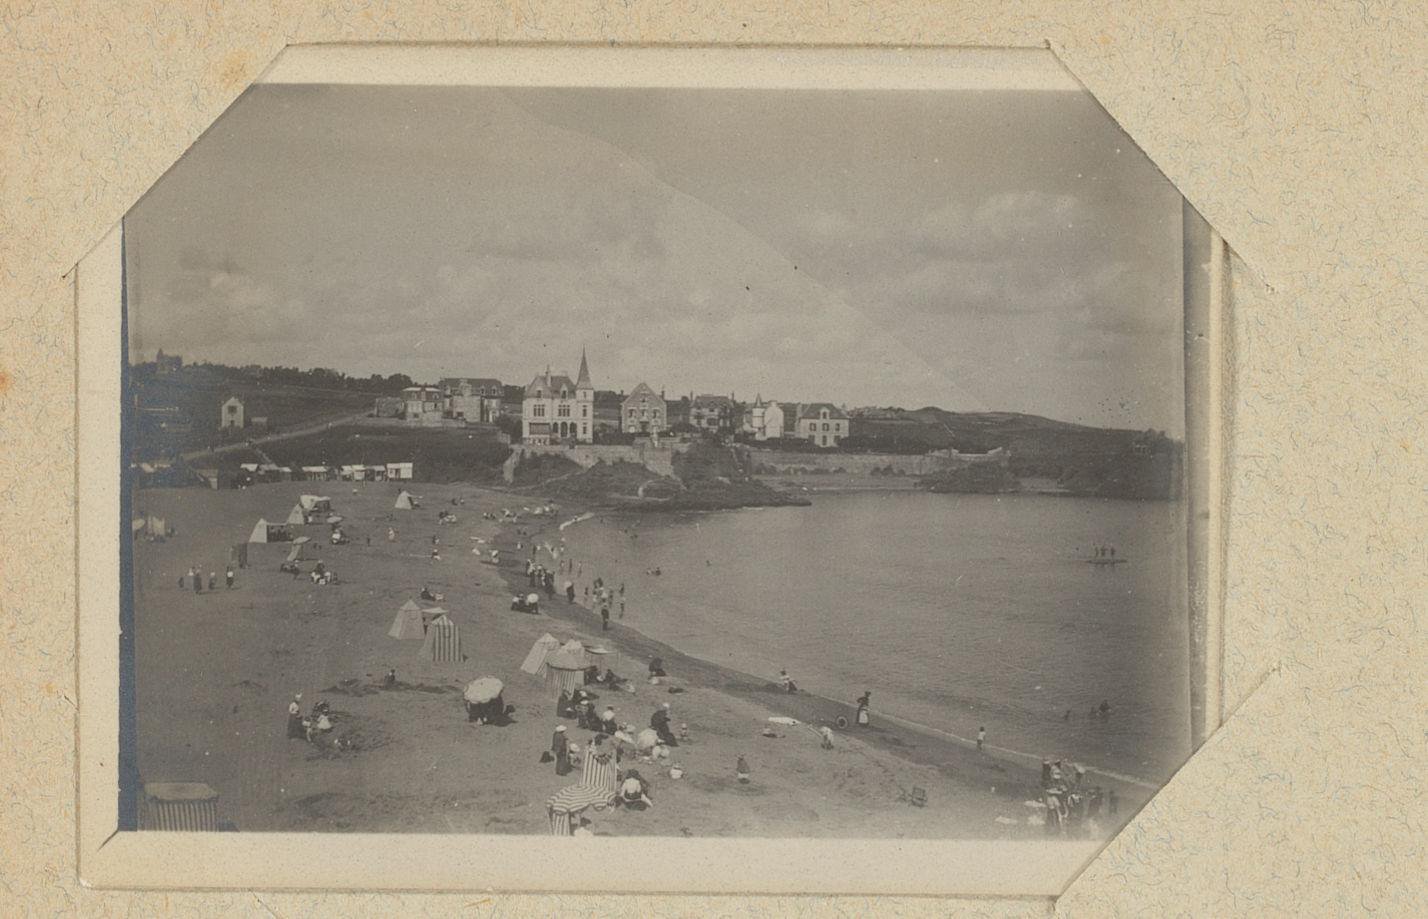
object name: photograph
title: Gezicht op een strand en een kustplaats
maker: Anonymous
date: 1897-1900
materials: paper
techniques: gelatin silver print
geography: france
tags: beach (as place of recreation), prospect of village, silhouette of village, france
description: Over de foto is een ander negatief afgedrukt van een voorstelling van bomen.